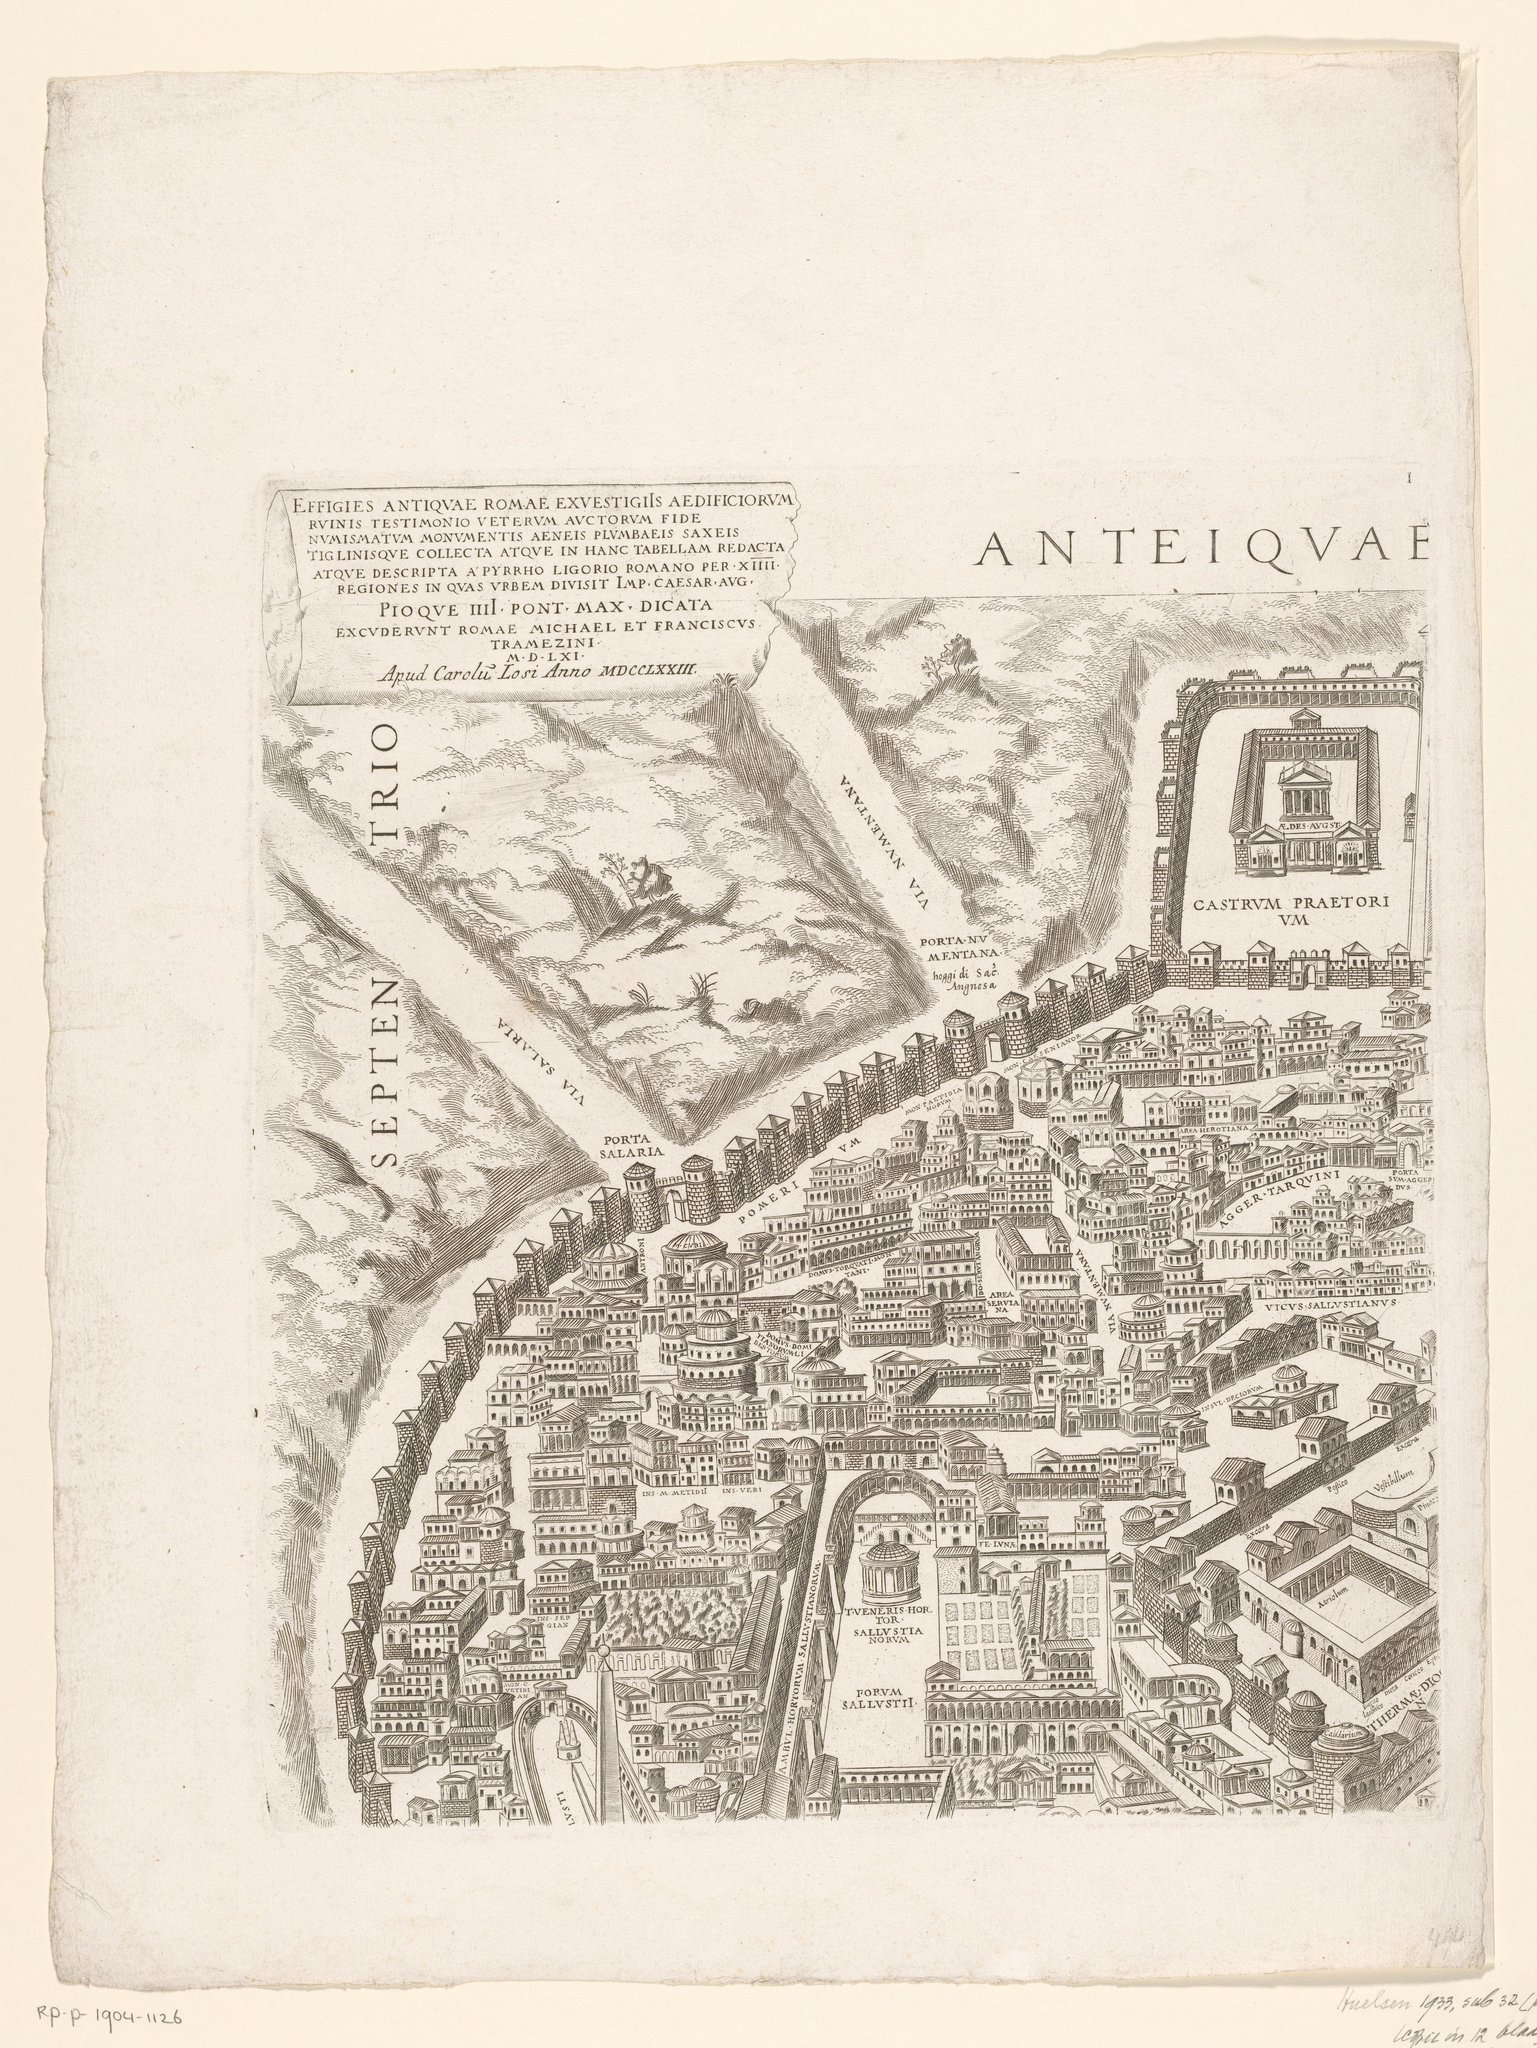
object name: area plan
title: Plattegrond van Rome in de Romeinse tijd (eerste deel)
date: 1773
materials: paper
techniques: engraving, etching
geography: rome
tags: maps of cities, rome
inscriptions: collector's mark: Lugt 2228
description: Eerste deel van een plattegrond van Rome in de Romeinse tijd, in vogelvluchtperspectief, bestaande uit twaalf delen. Rechtsboven genummerd: 1.